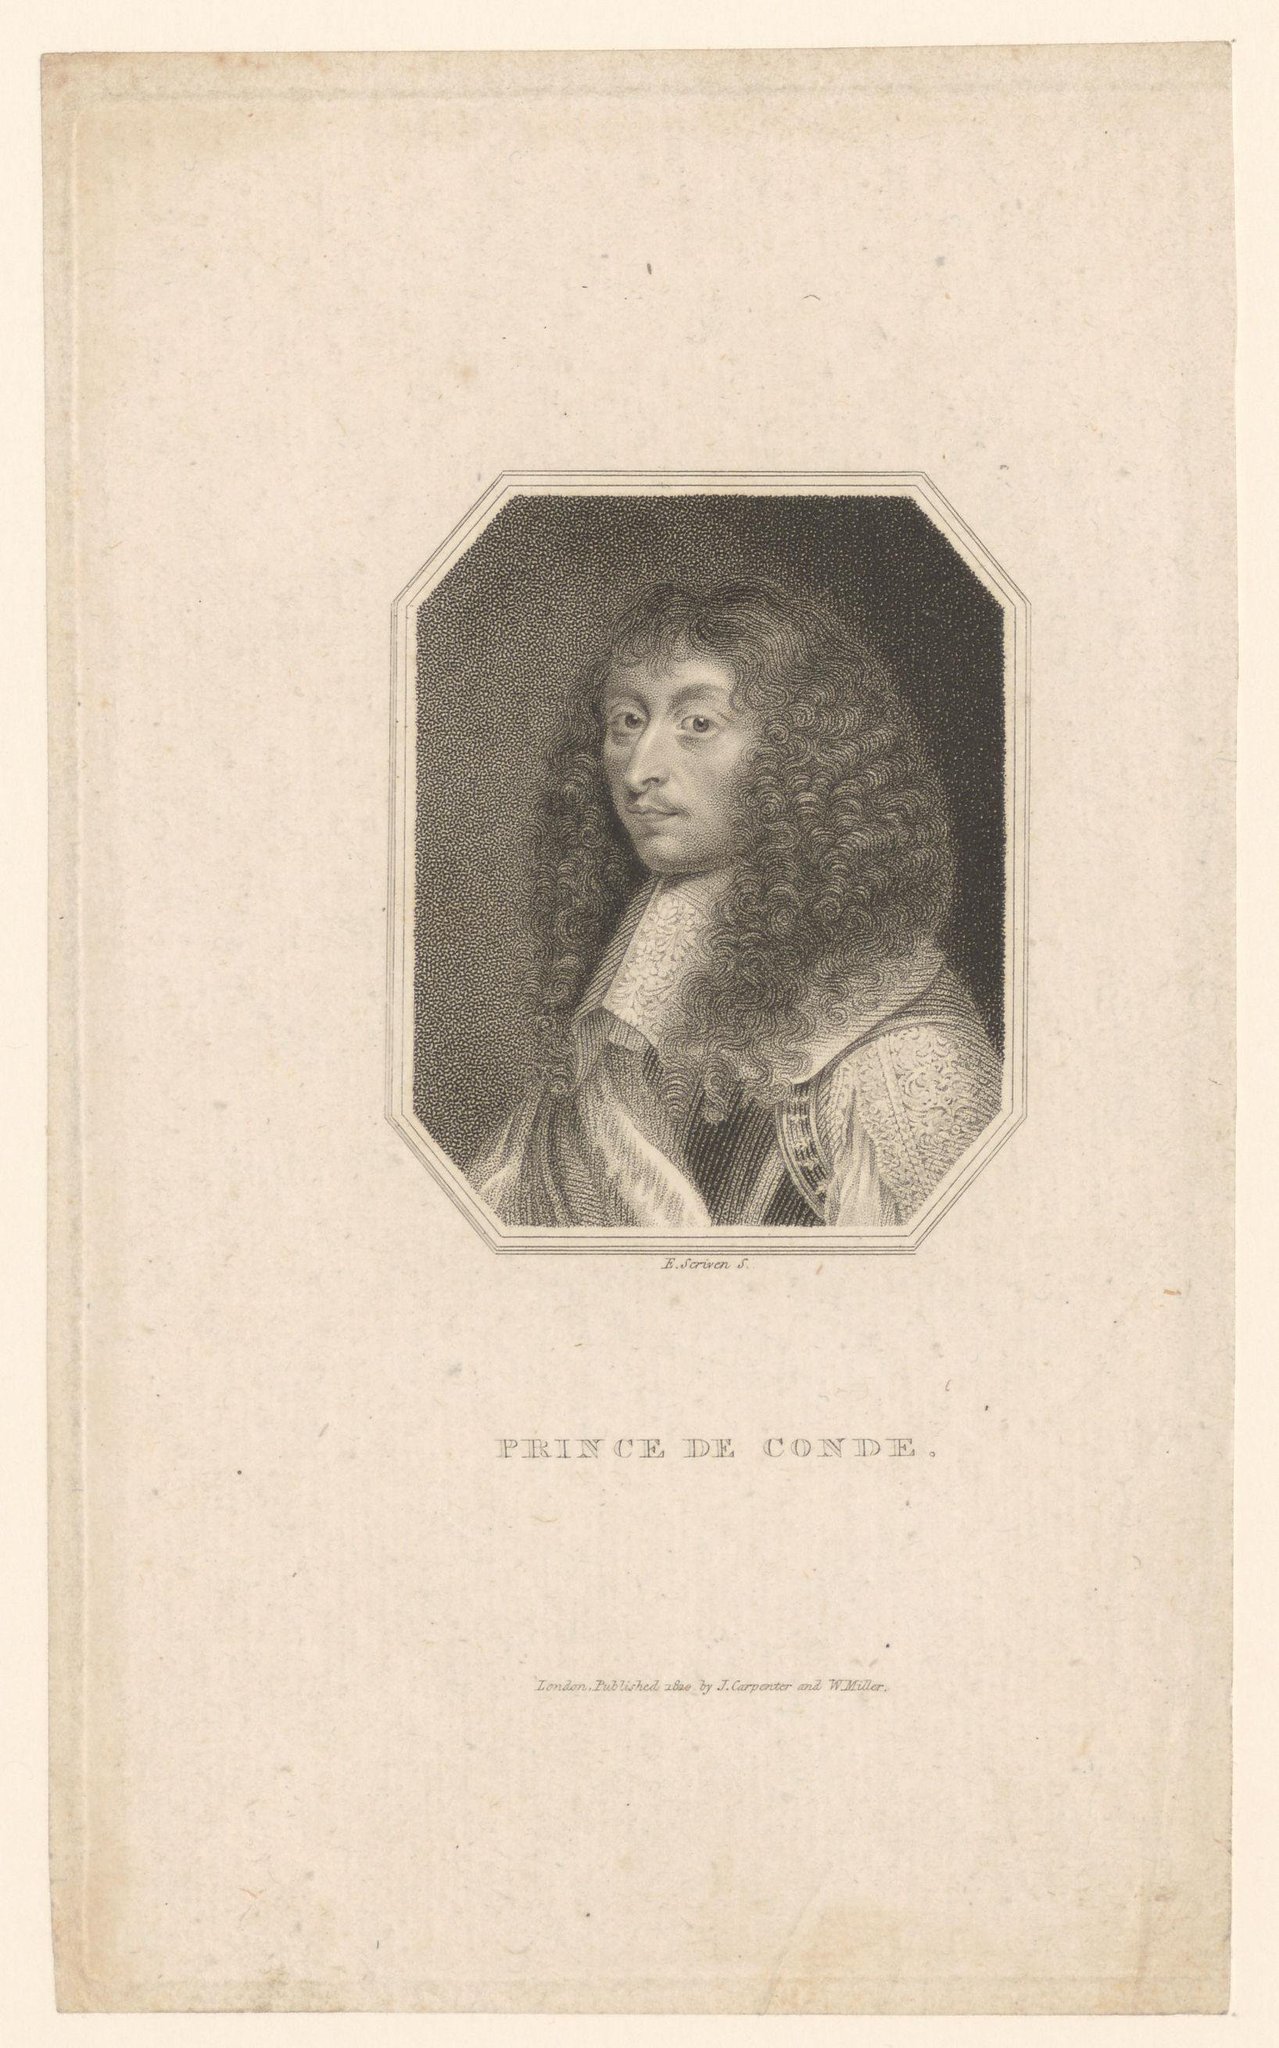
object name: print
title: Portret van Lodewijk II van Bourbon-Condé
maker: edward scriven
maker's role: print maker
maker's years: 1775-1841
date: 1810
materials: paper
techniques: etching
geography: london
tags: paris, lodewijk ii de bourbon-condé (hertog van enghien), commander-in-chief, general, marshal, historical persons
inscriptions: collector's mark: Lugt 2228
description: Prent gebruikt in: Hamilton, Anthony. Memoirs of Count Grammont. Londen: Carpenter & Miller, 1811.